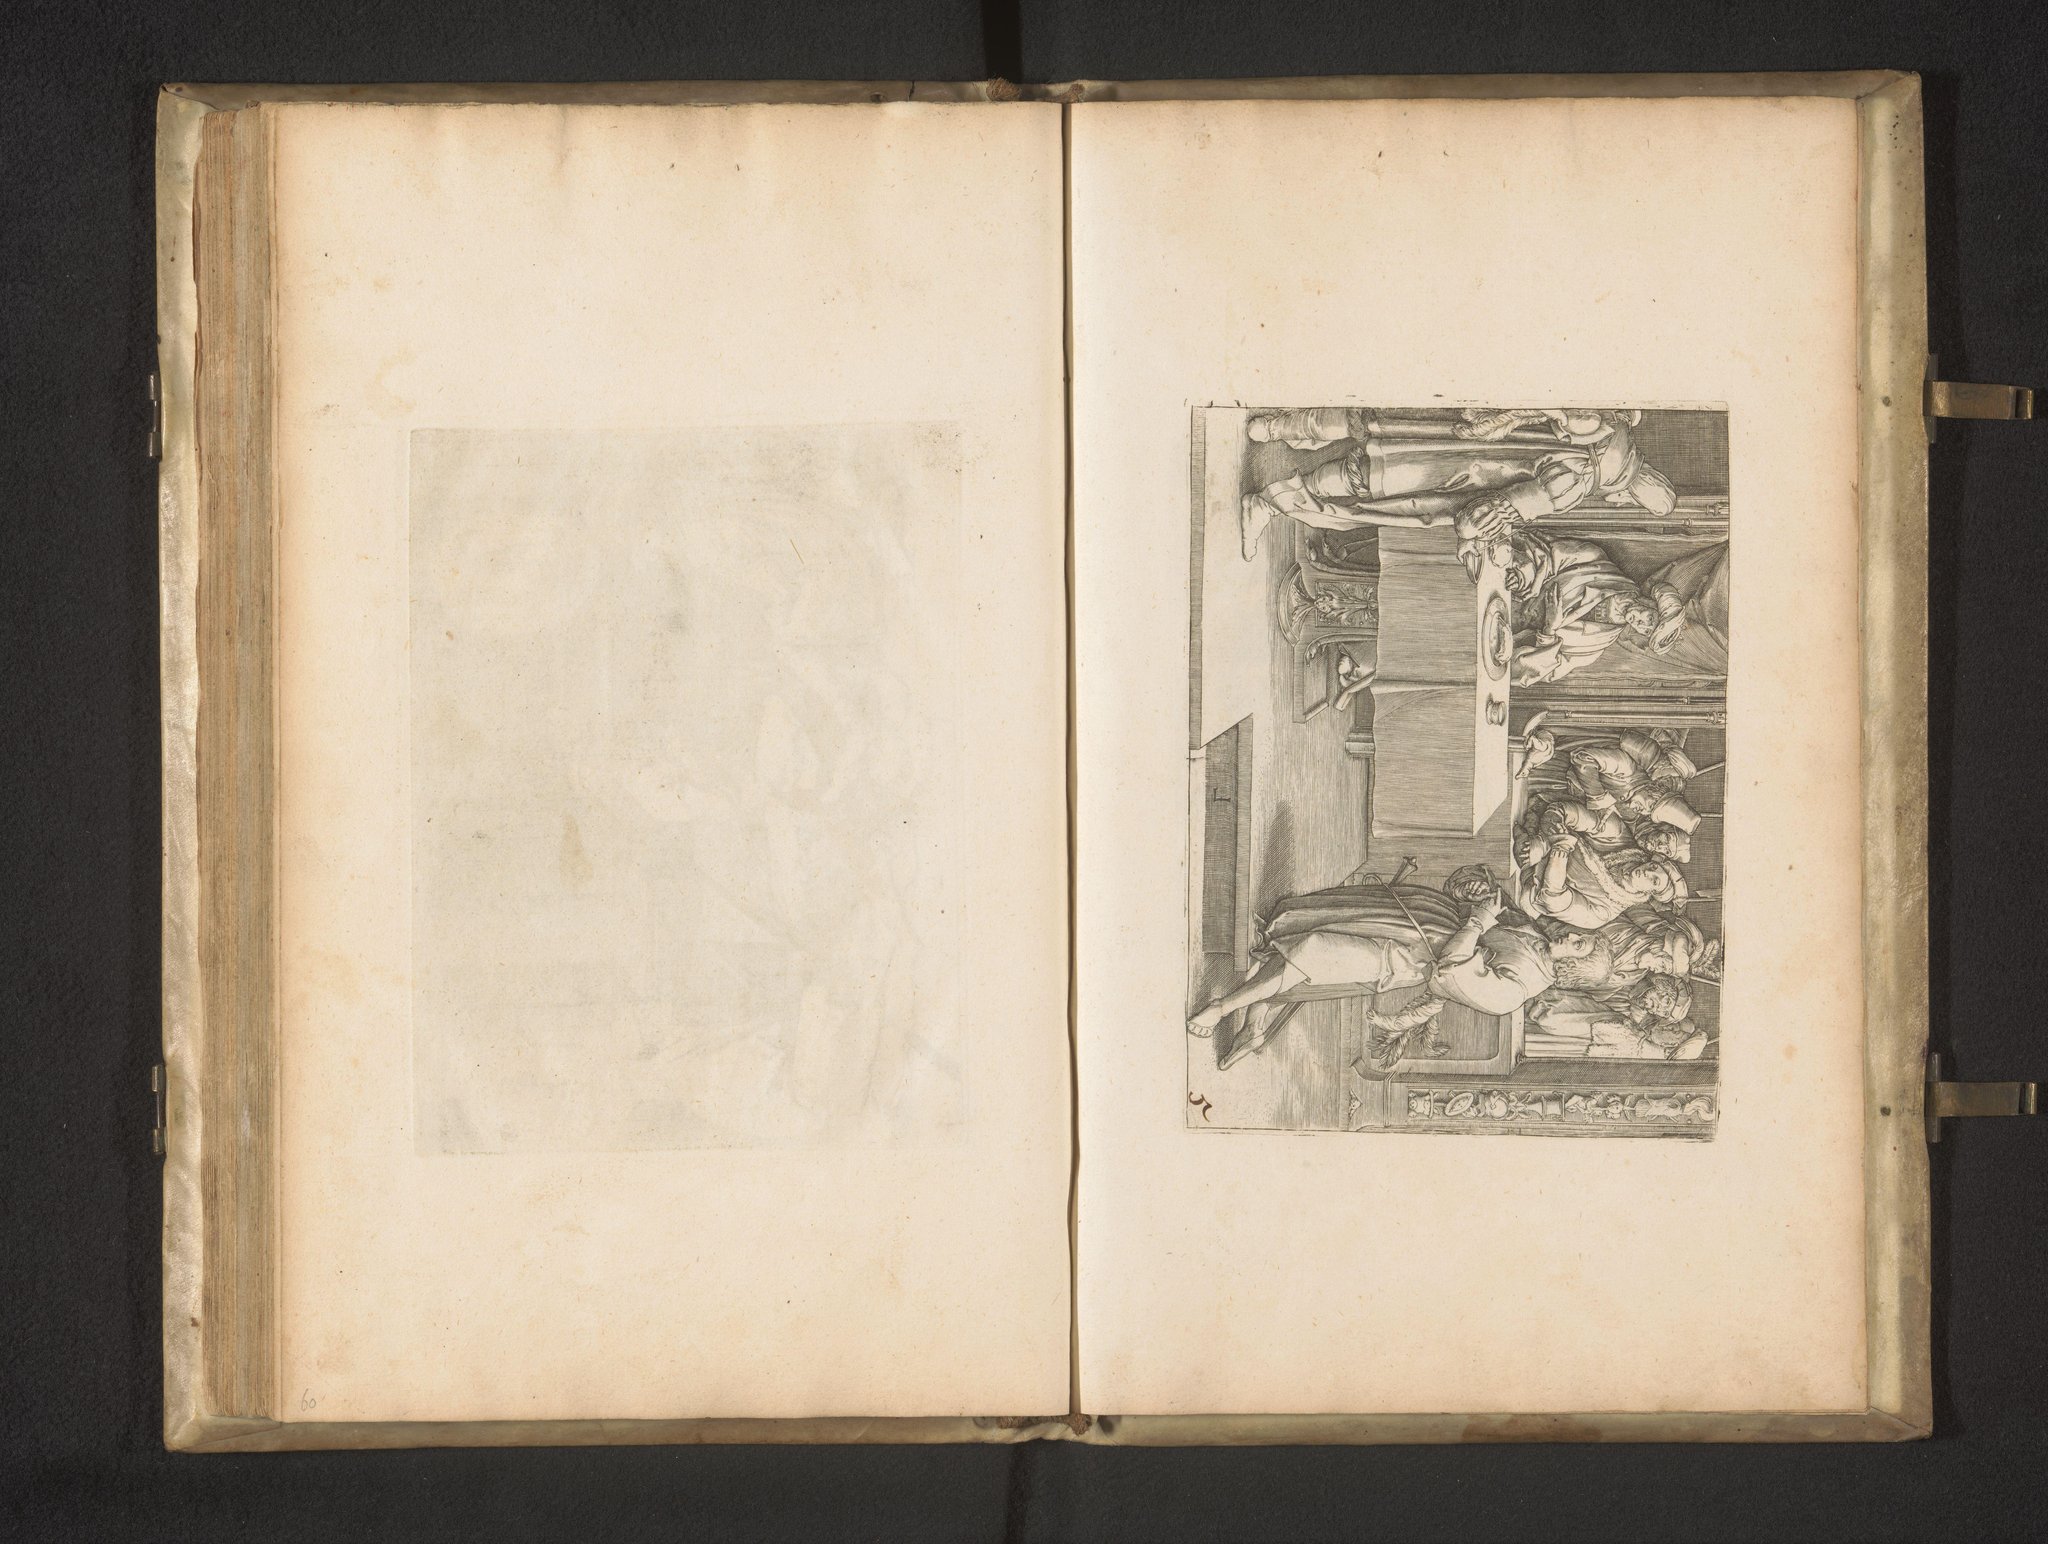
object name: print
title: Jozef verklaart de dromen van Farao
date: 1581-1628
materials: paper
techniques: engraving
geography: amsterdam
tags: joseph interpreting pharaoh's dreams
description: Farao aan tafel, Jozef ernaast geknield en legt zijn dromen uit. Een groep mensen luistert mee vanachter een balustrade. Onderdeel van een serie van vijf prenten van de geschiedenis van Jozef. Met de hand genummerd rechtsonder: 5. Onderdeel van een album met voornamelijk christelijke voorstellingen.